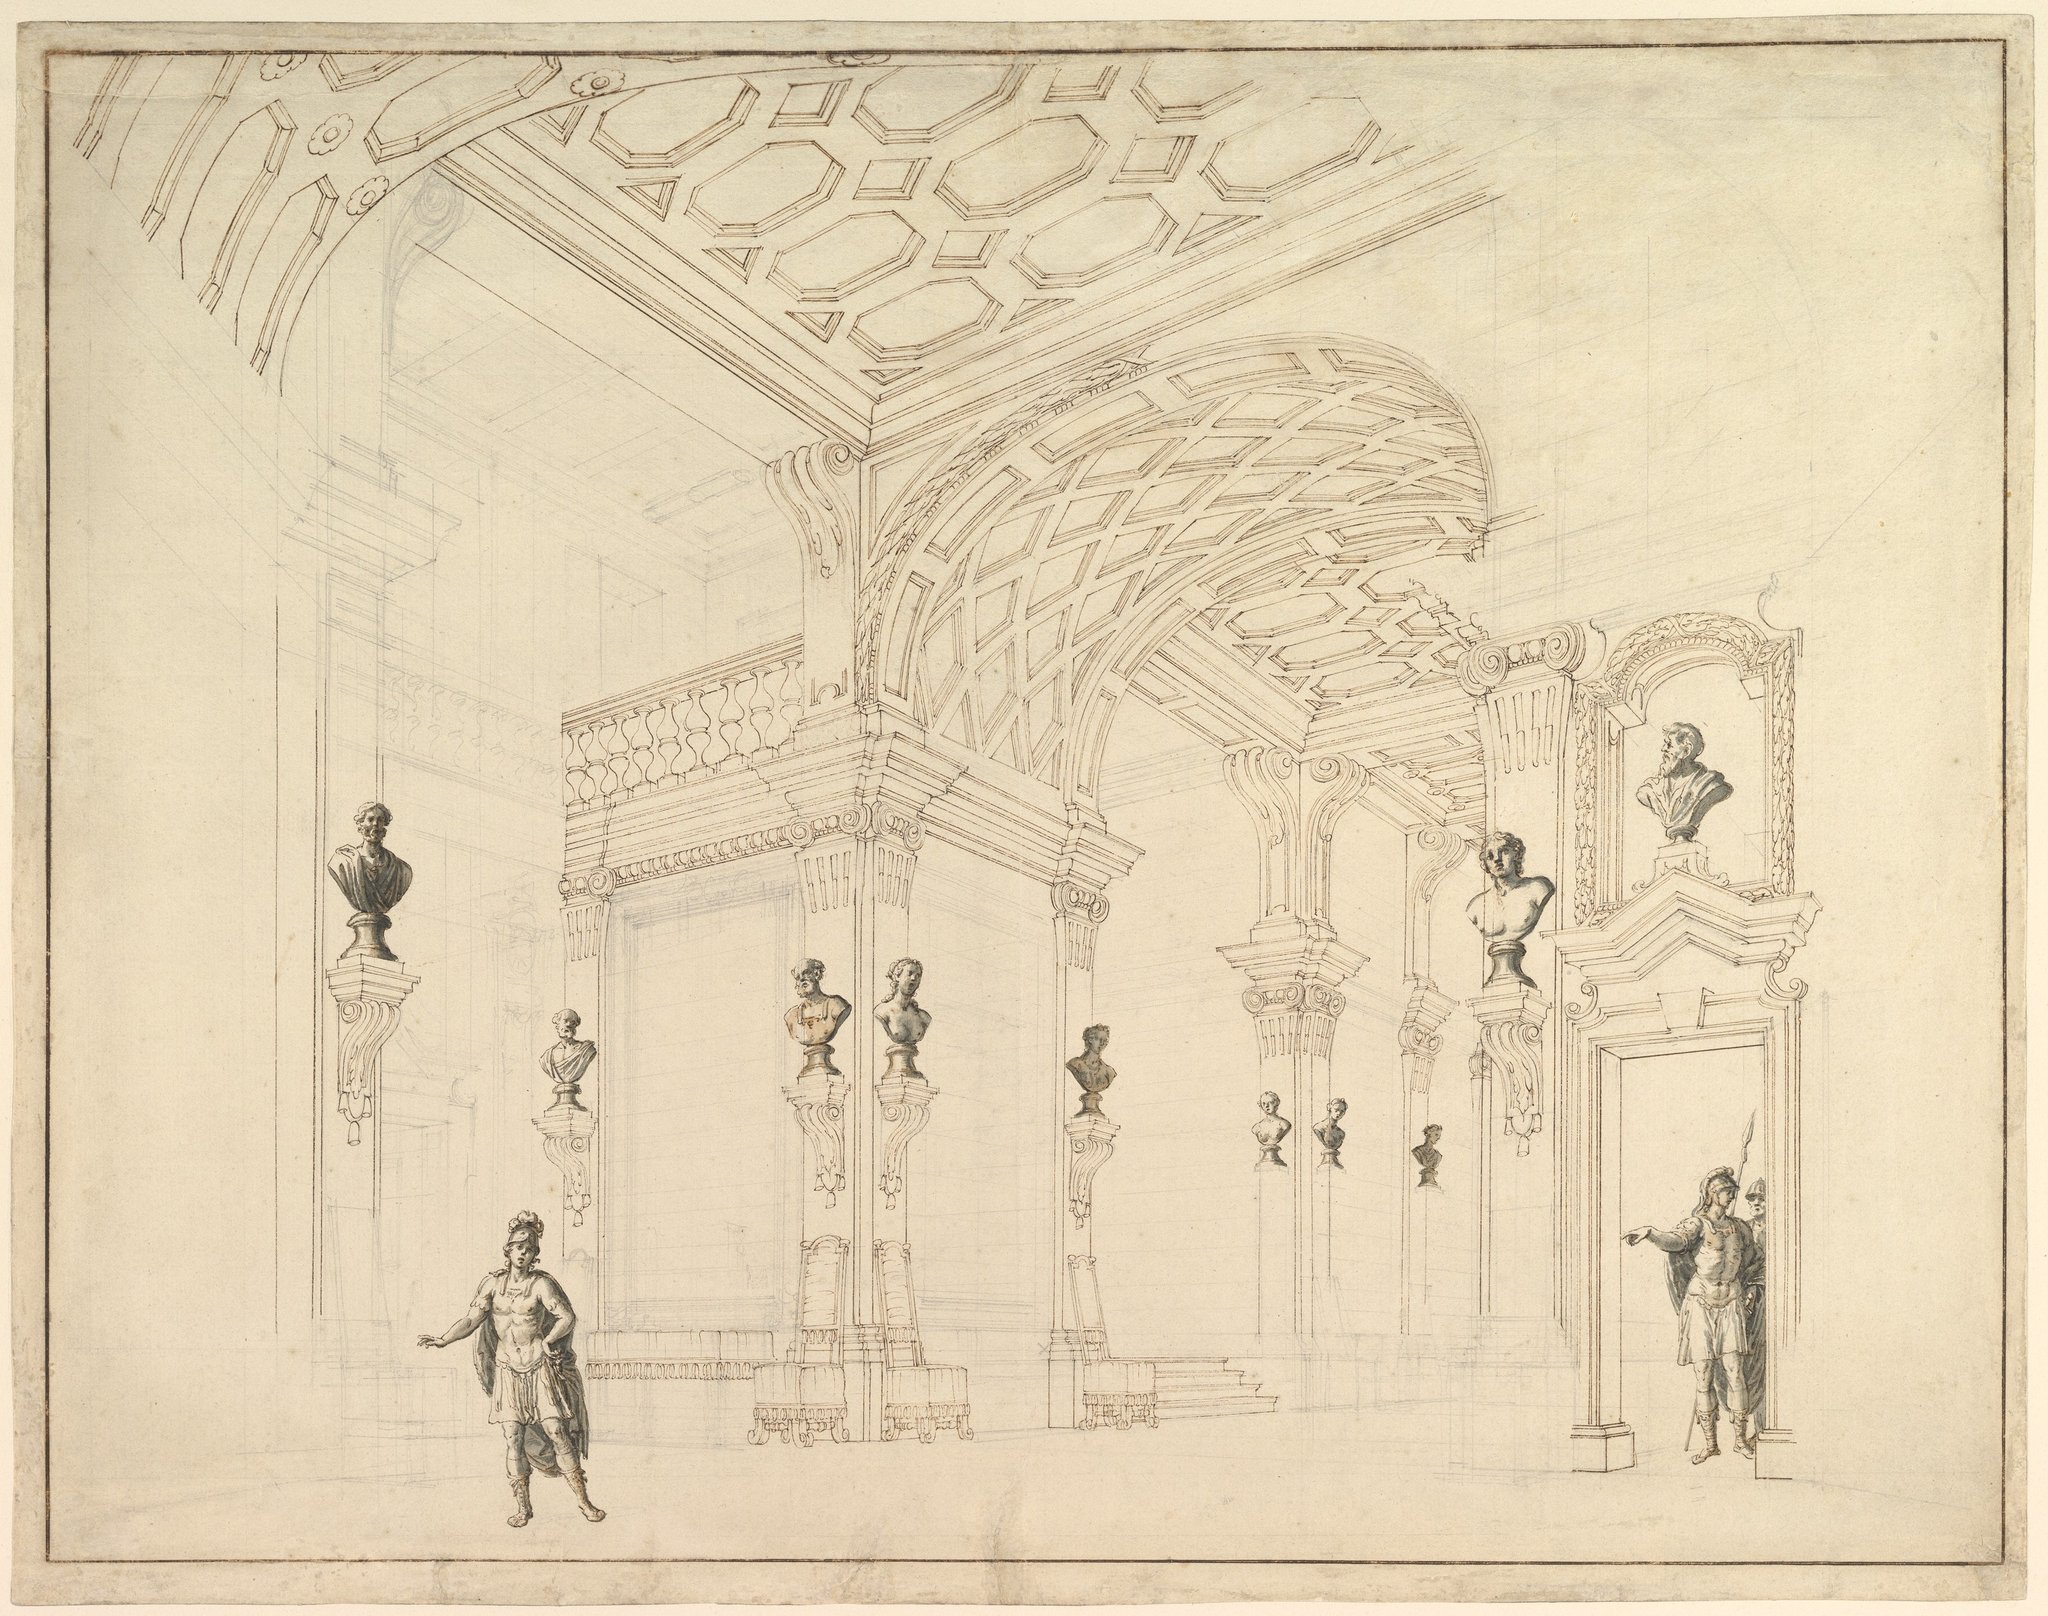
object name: drawing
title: Design for a Stage Set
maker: giuseppe galli bibiena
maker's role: artist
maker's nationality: italian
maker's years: 1696-1756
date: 1696-1756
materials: chalk, ink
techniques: brush, pen, wash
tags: interiors,men,stage design